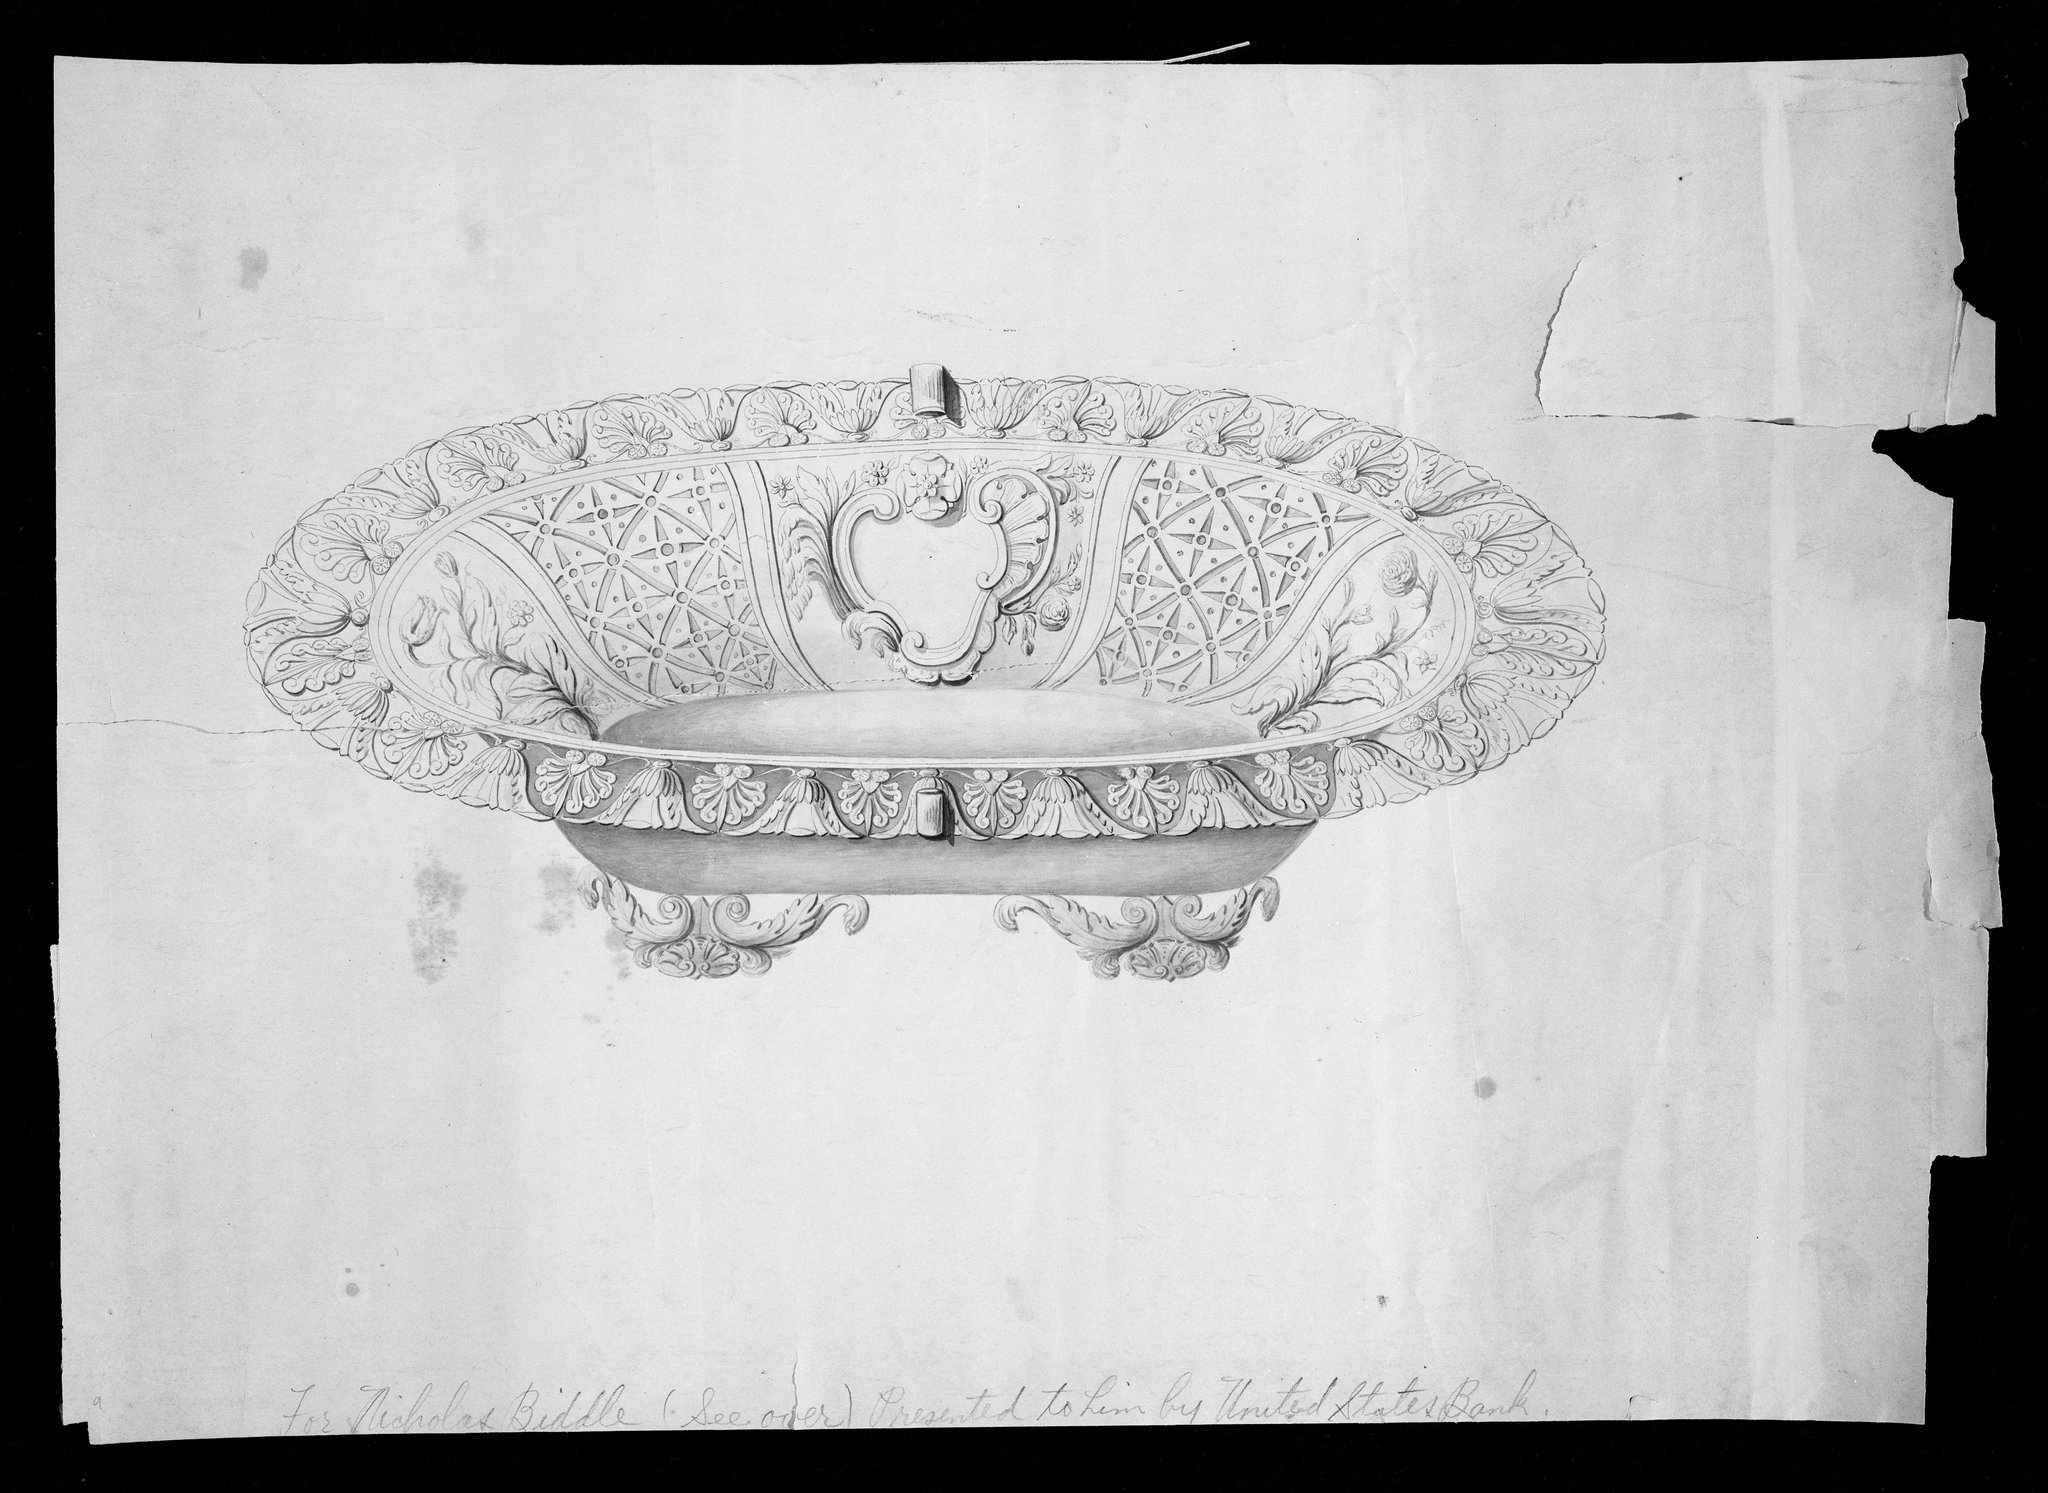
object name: drawing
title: Design for a fruit or bread basket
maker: thomas fletcher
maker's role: artist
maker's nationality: american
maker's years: 1787-1866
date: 1836-1837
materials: ink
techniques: pen, wash